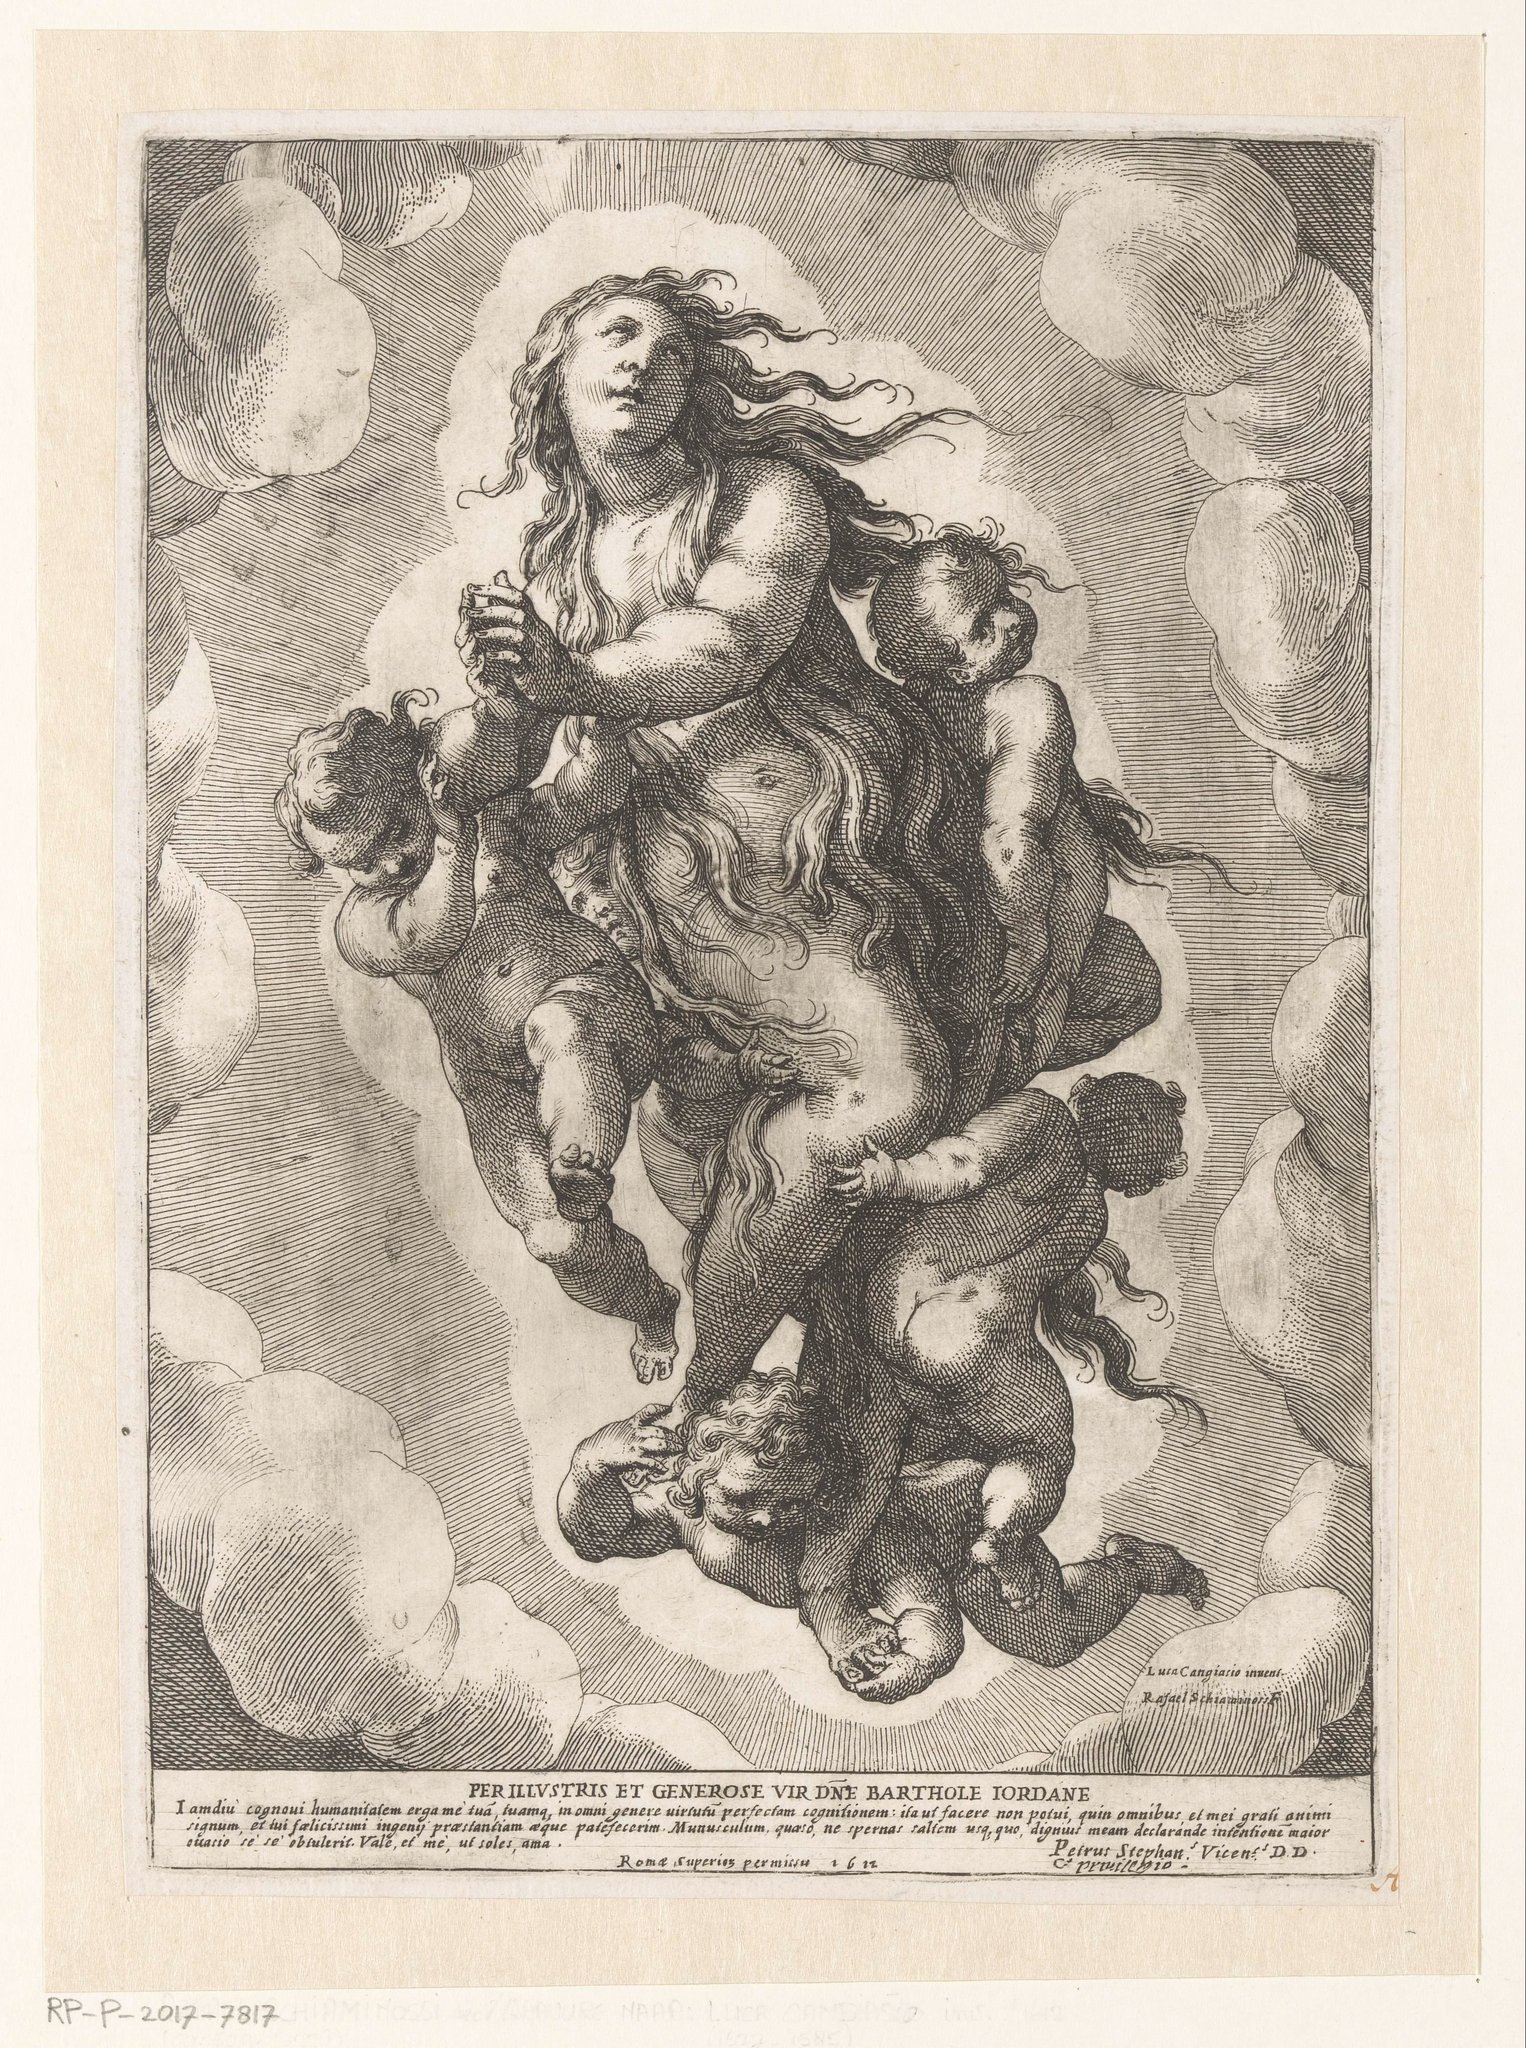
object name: print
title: Hemelvaart van Maria Magdalena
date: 1612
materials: paper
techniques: engraving, etching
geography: italy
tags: the assumption of st. mary magdalene: she is lifted up to heaven by angels; sometimes a hermit looks up at her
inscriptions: collector's mark: Lugt 2228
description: Maria Magdalena, haar naakte lichaam gedeeltelijk bedekt door haar lange haren, wordt omhooggevoerd naar de hemel door vijf engelen. Opdracht en drieregelige Latijnse tekst in ondermarge.